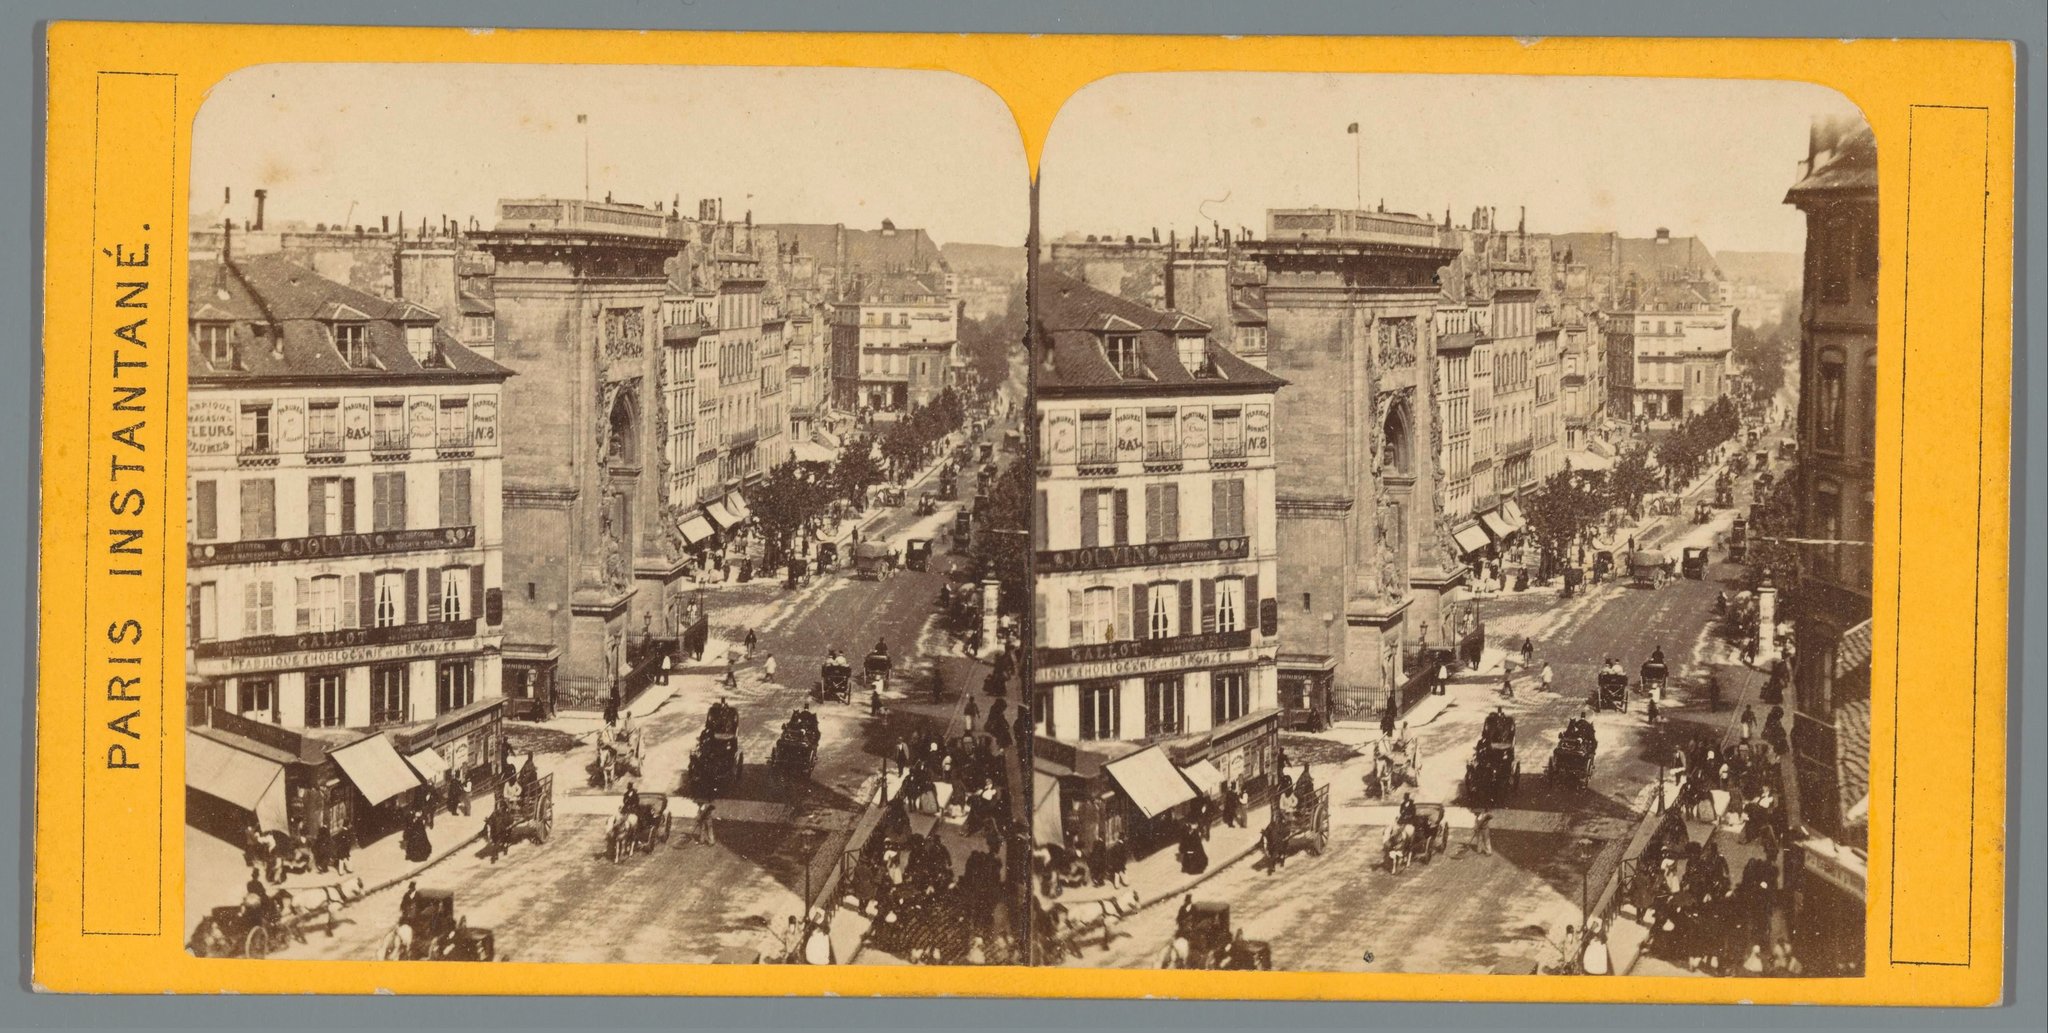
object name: stereograph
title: Gezicht op Boulevard Saint-Denis en de Porte Saint-Denis in Parijs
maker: Anonymous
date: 1850-1880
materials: cardboard, photographic support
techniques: albumen print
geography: paris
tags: animal traction, animal-drawn vehicle (carriage etc.), gate, entrance, street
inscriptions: inscription: ‘Boulevard St Denis, Parijs’